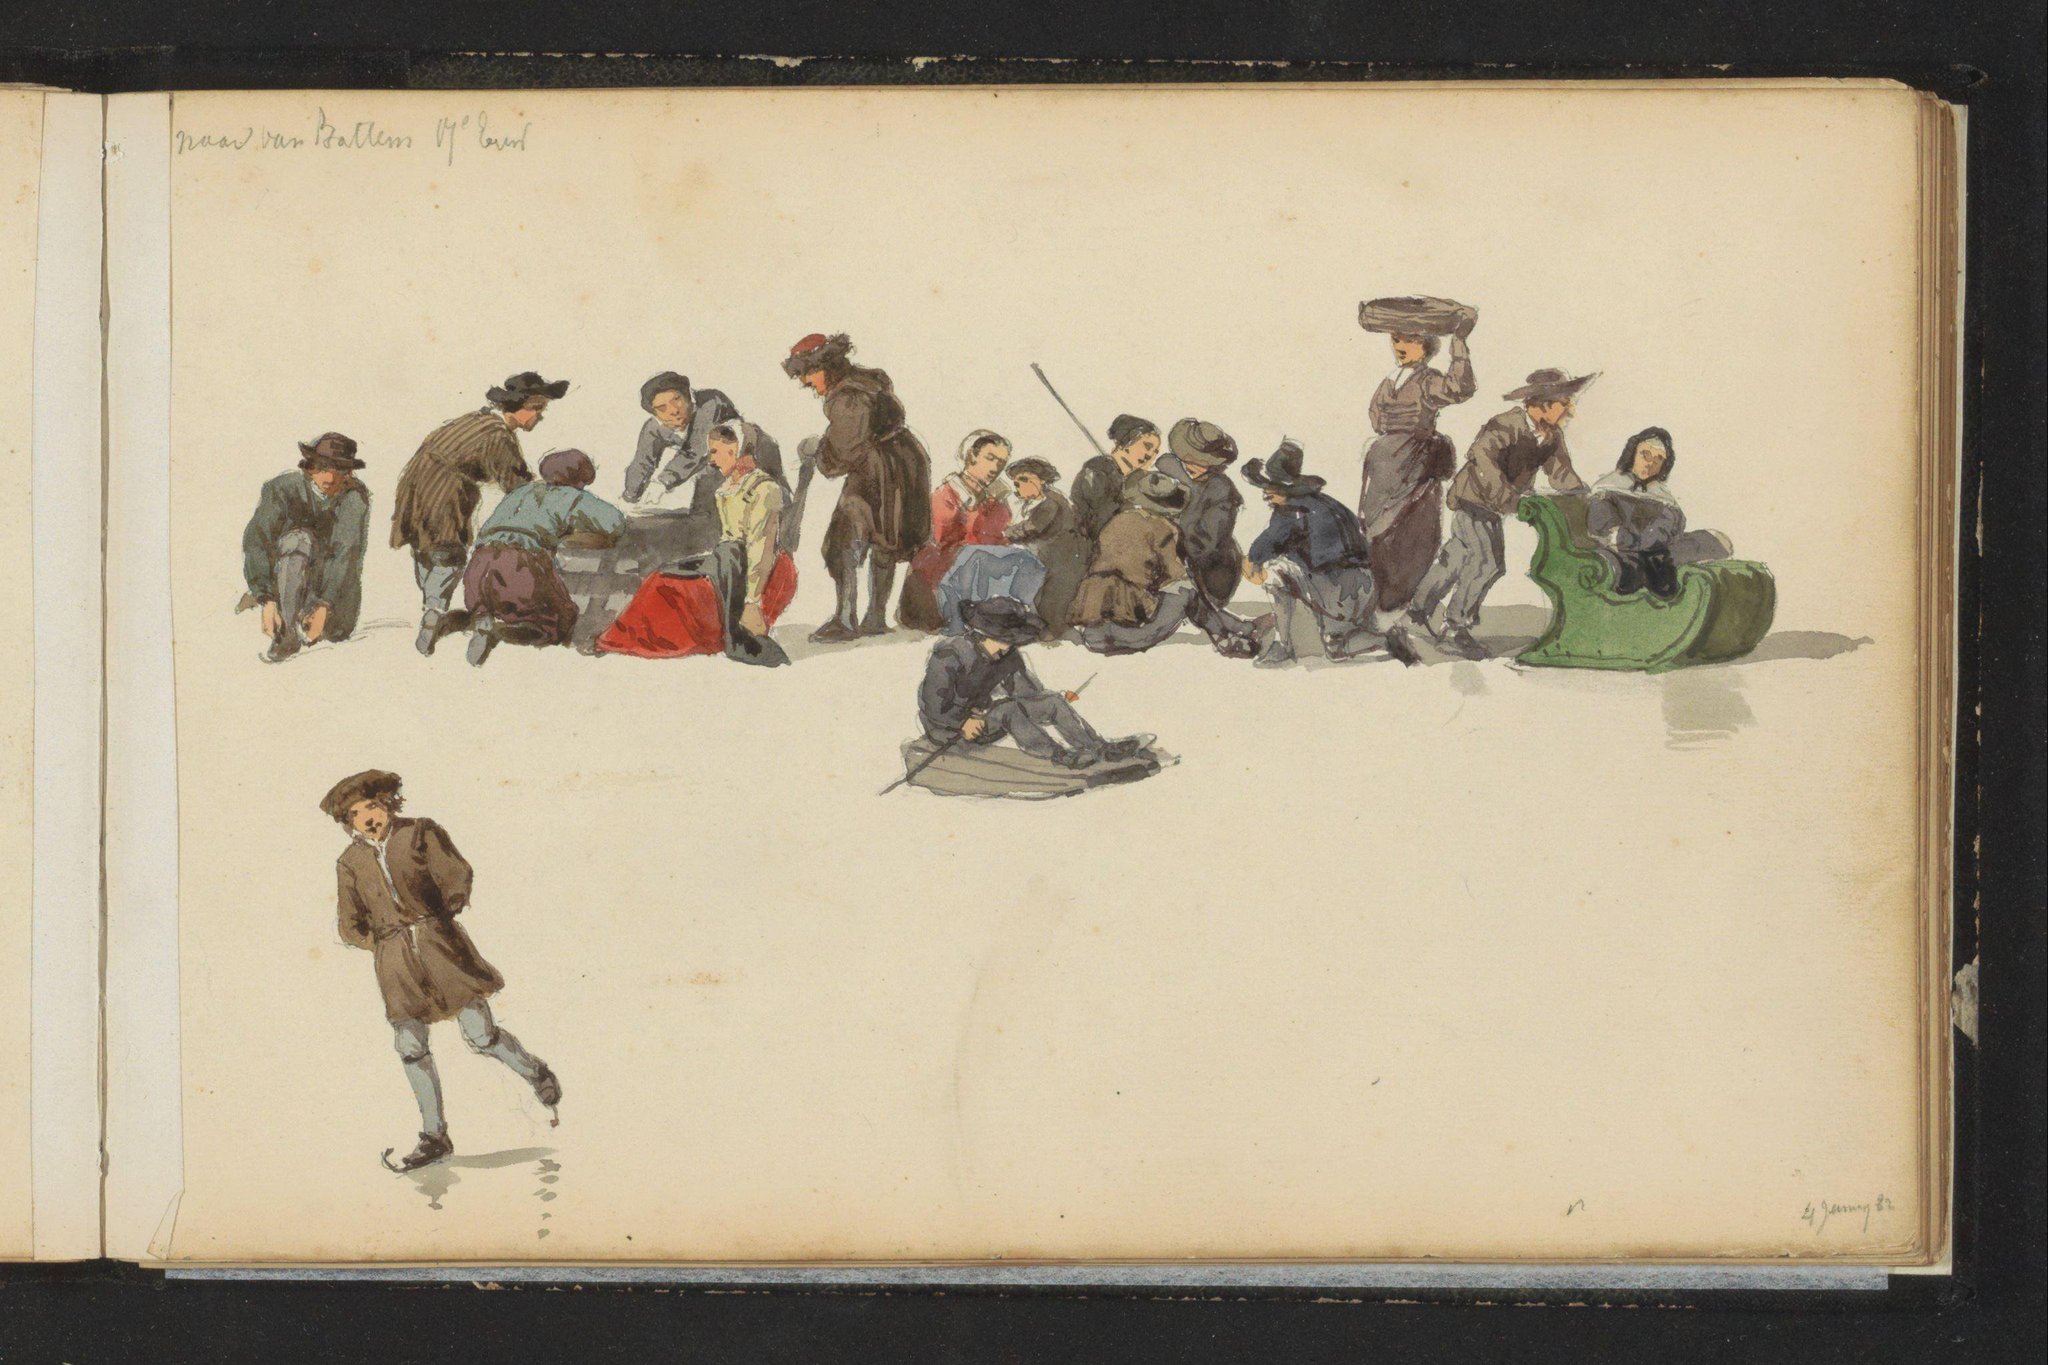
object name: sketchbook leaf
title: Figuren in zeventiende-eeuwse kleding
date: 1882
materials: paper, pencil, watercolor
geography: netherlands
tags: adult woman, winter sports, adult man, clothes, costume (+ women's clothes), clothes, costume (+ men's clothes)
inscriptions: date: ‘4 January 82’, annotation: ‘naar van Battem 17e eeuw’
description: Figuren in zeventiende-eeuwse kleding. Linksboven bindt een figuur zijn schaatsen onder. Rechtsboven wordt gesleed. Linksonder een schaatsende figuur. Blad 53 uit een schetsboek met 91 bladen.